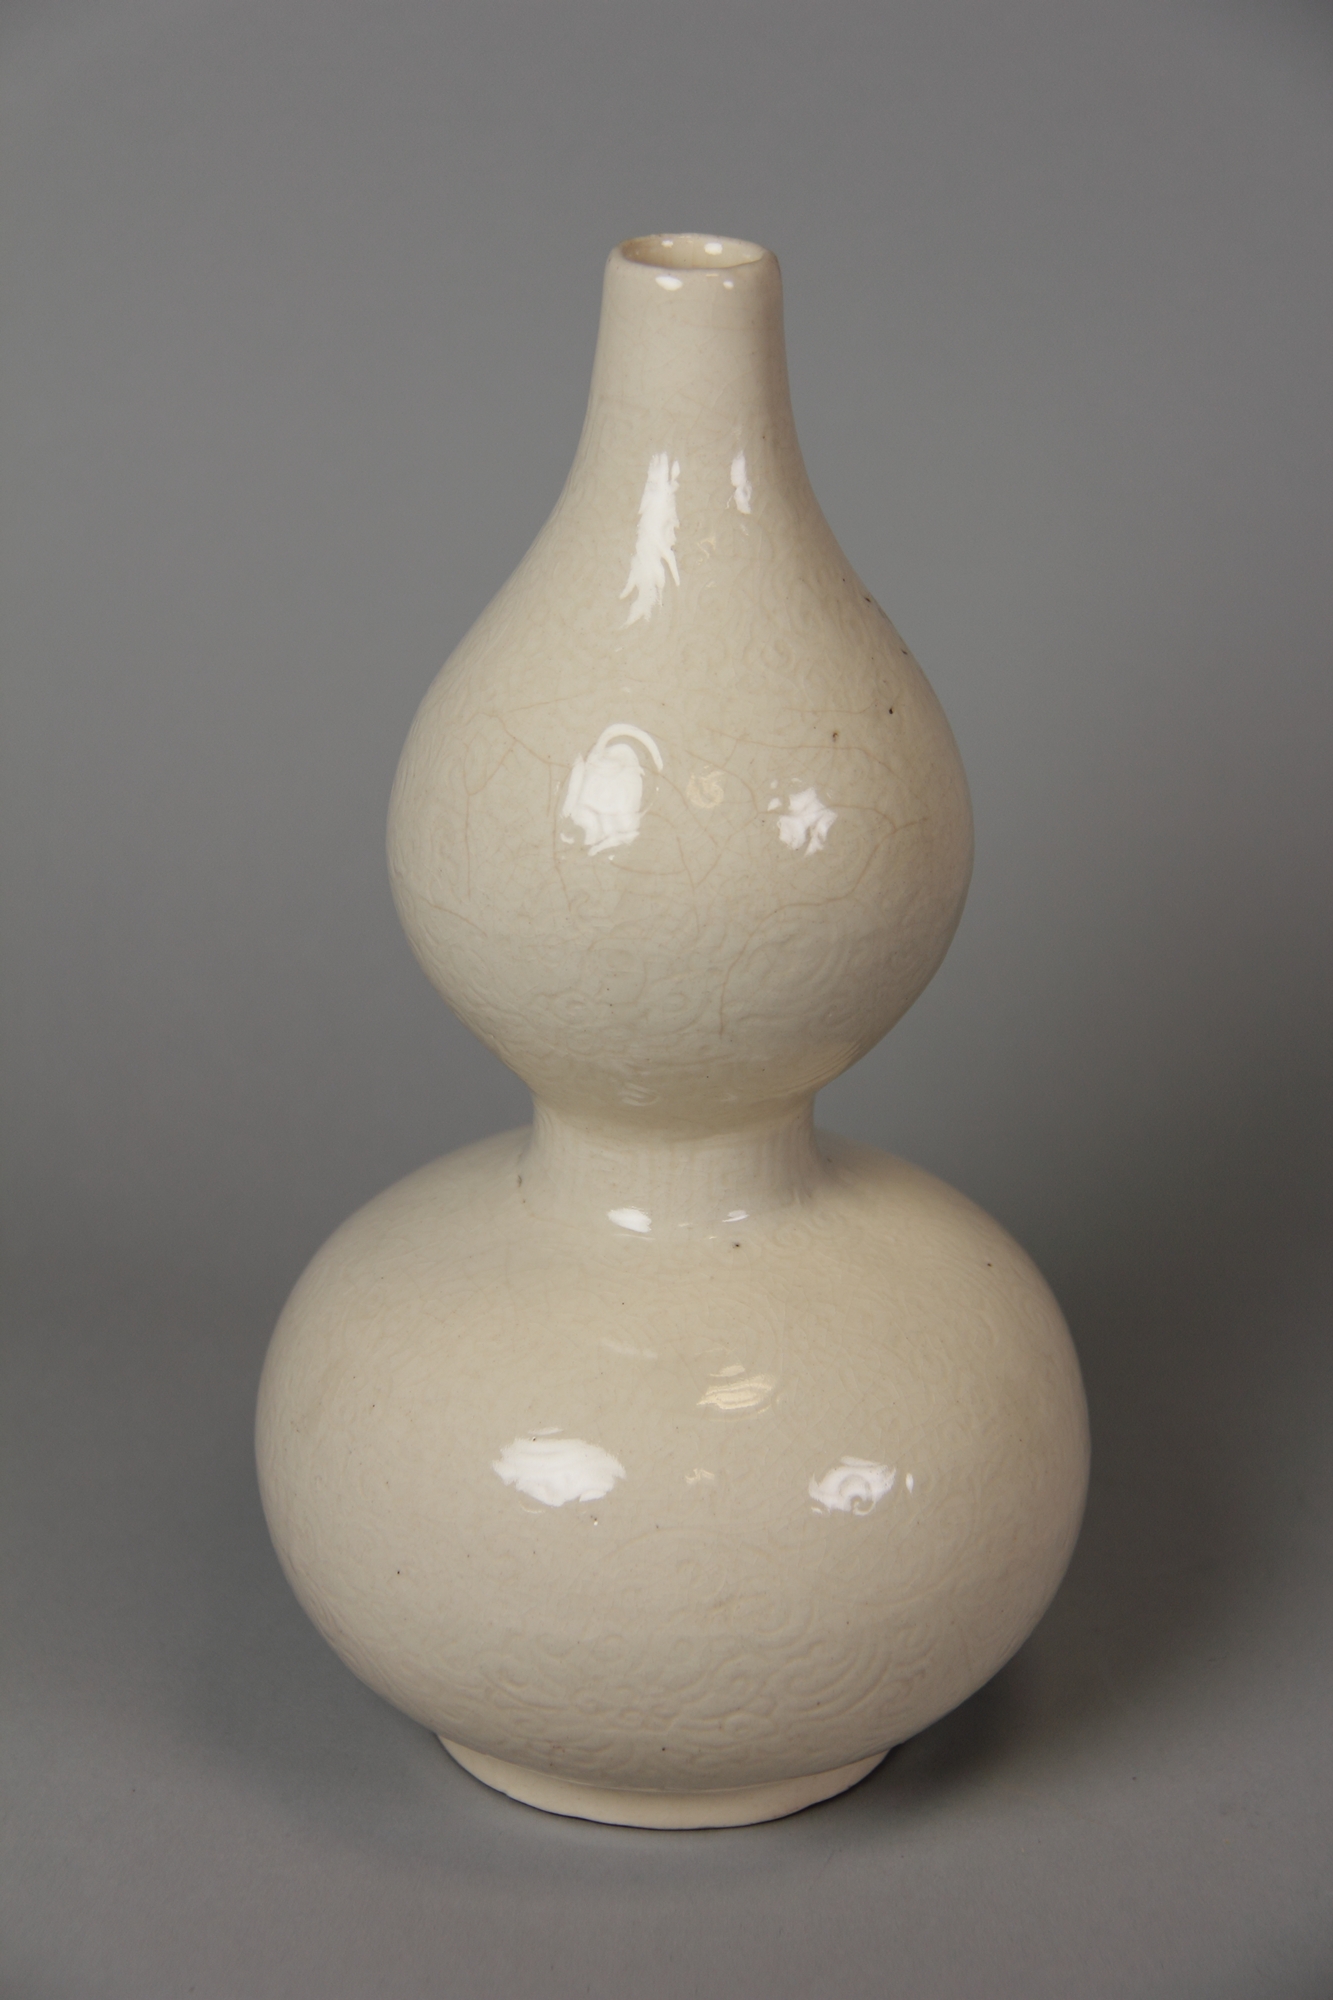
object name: vase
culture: chinese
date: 1801-1850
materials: glaze, porcelain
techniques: incising